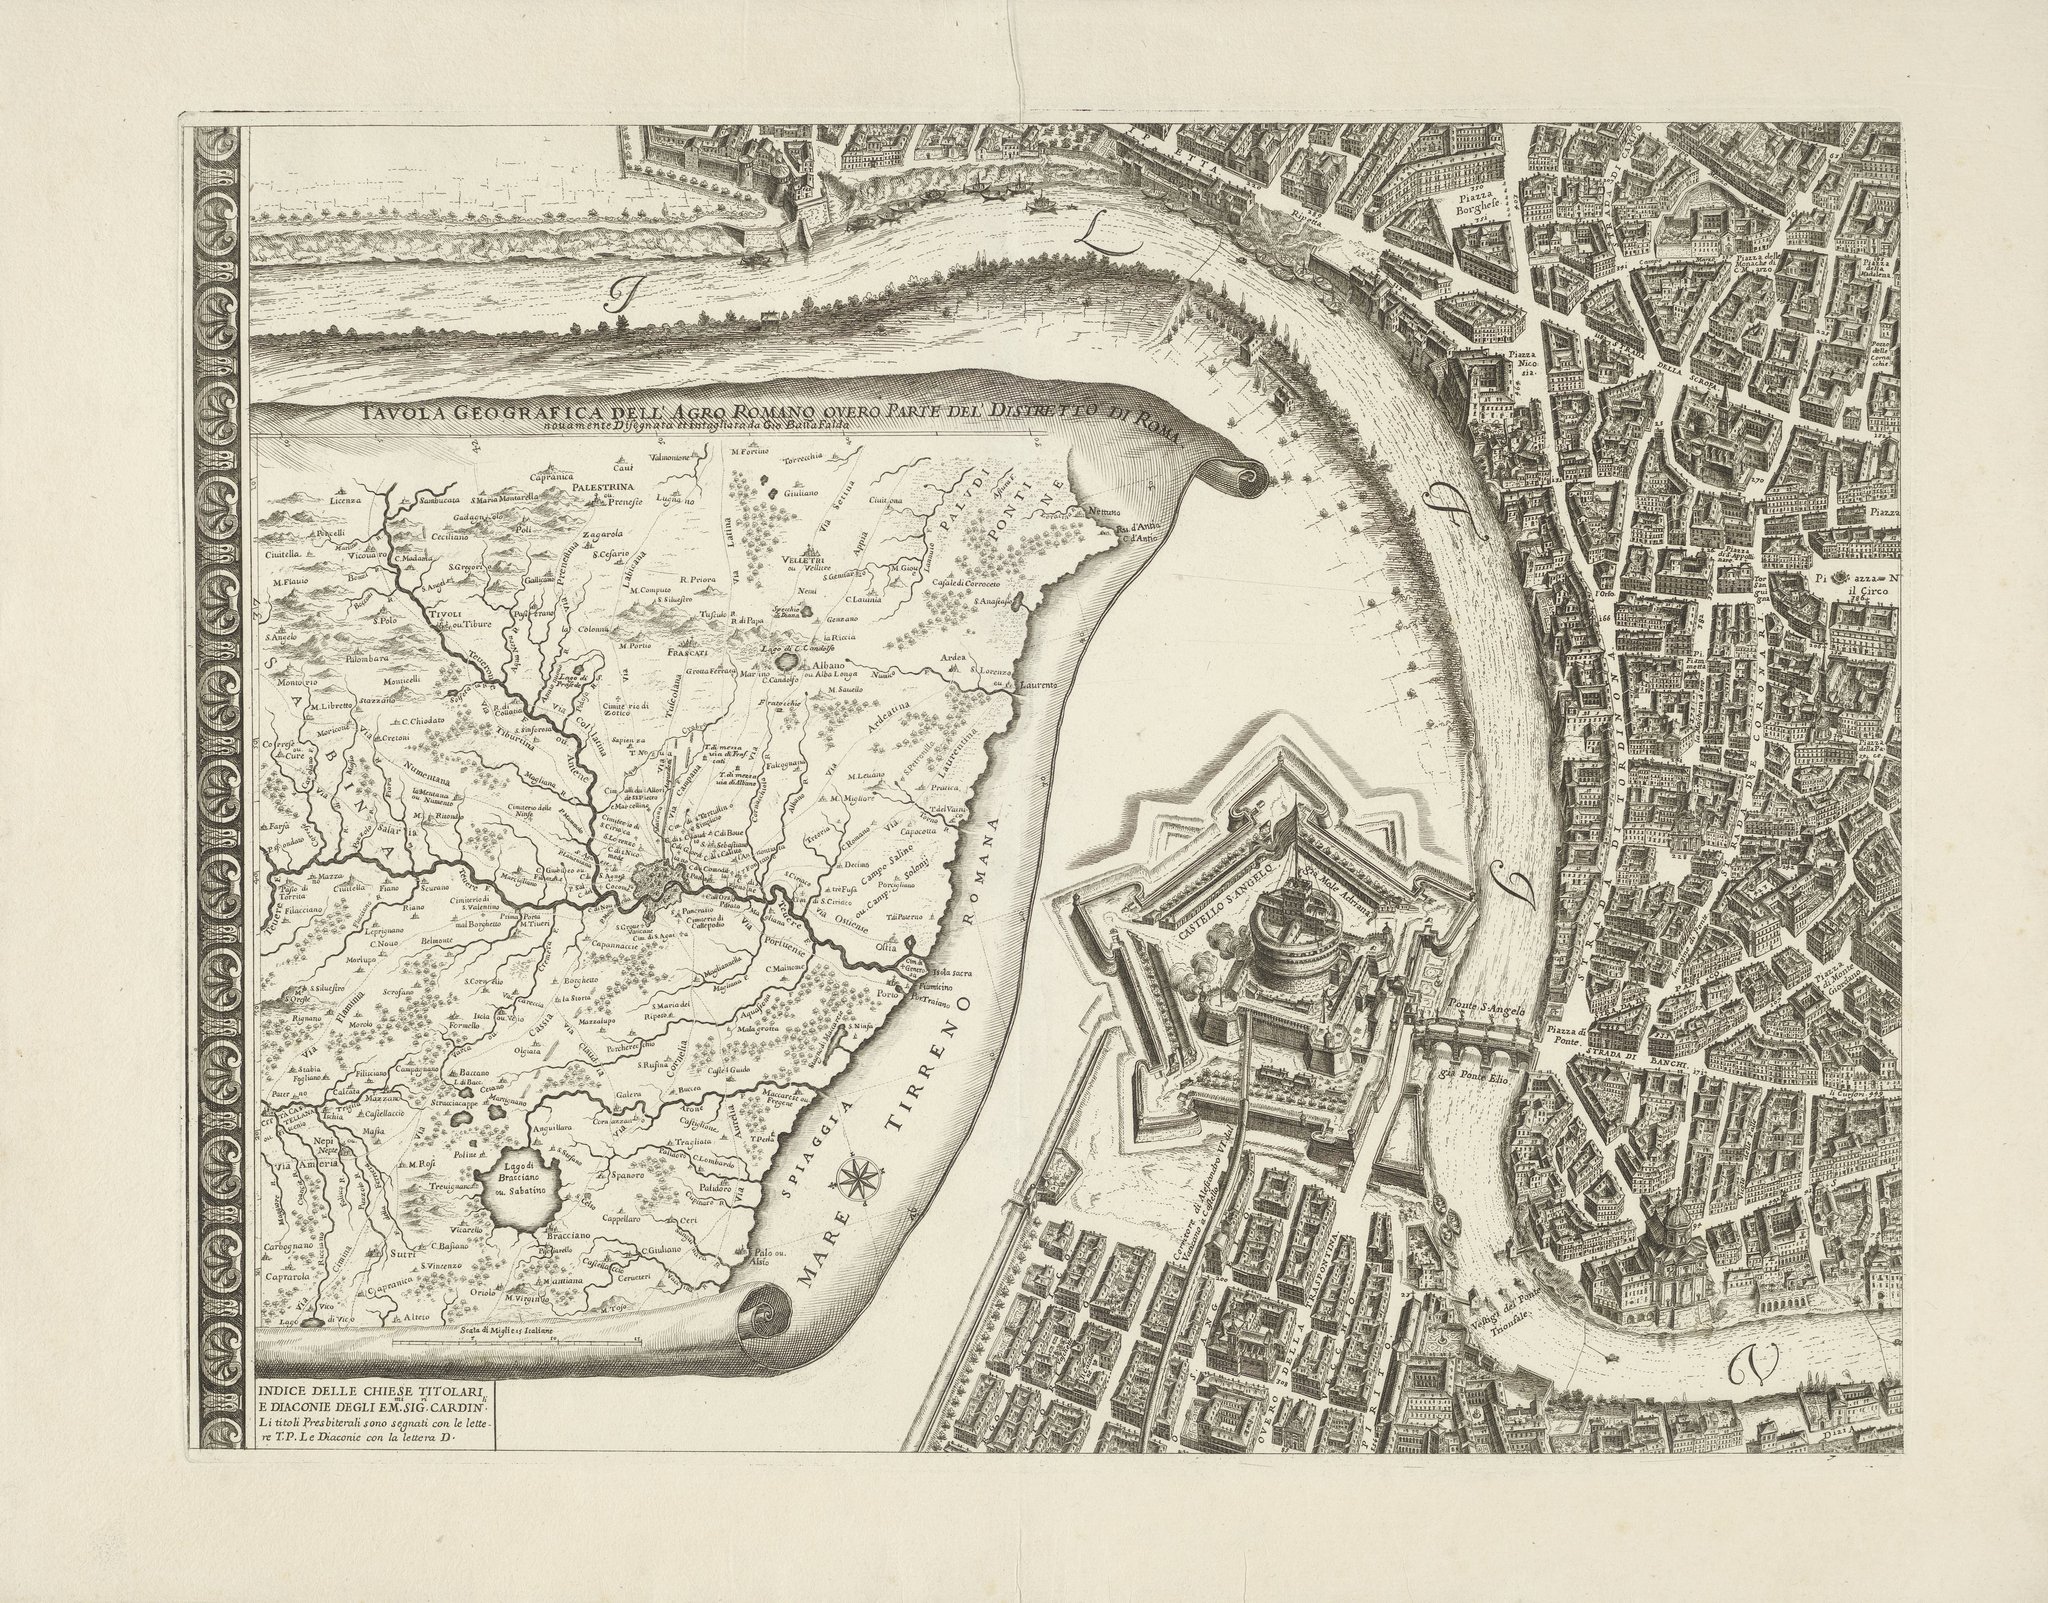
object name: print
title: Plattegrond van de stad Rome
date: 1676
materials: paper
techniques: etching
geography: rome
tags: maps, atlases, rome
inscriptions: collector's mark: Lugt 2228